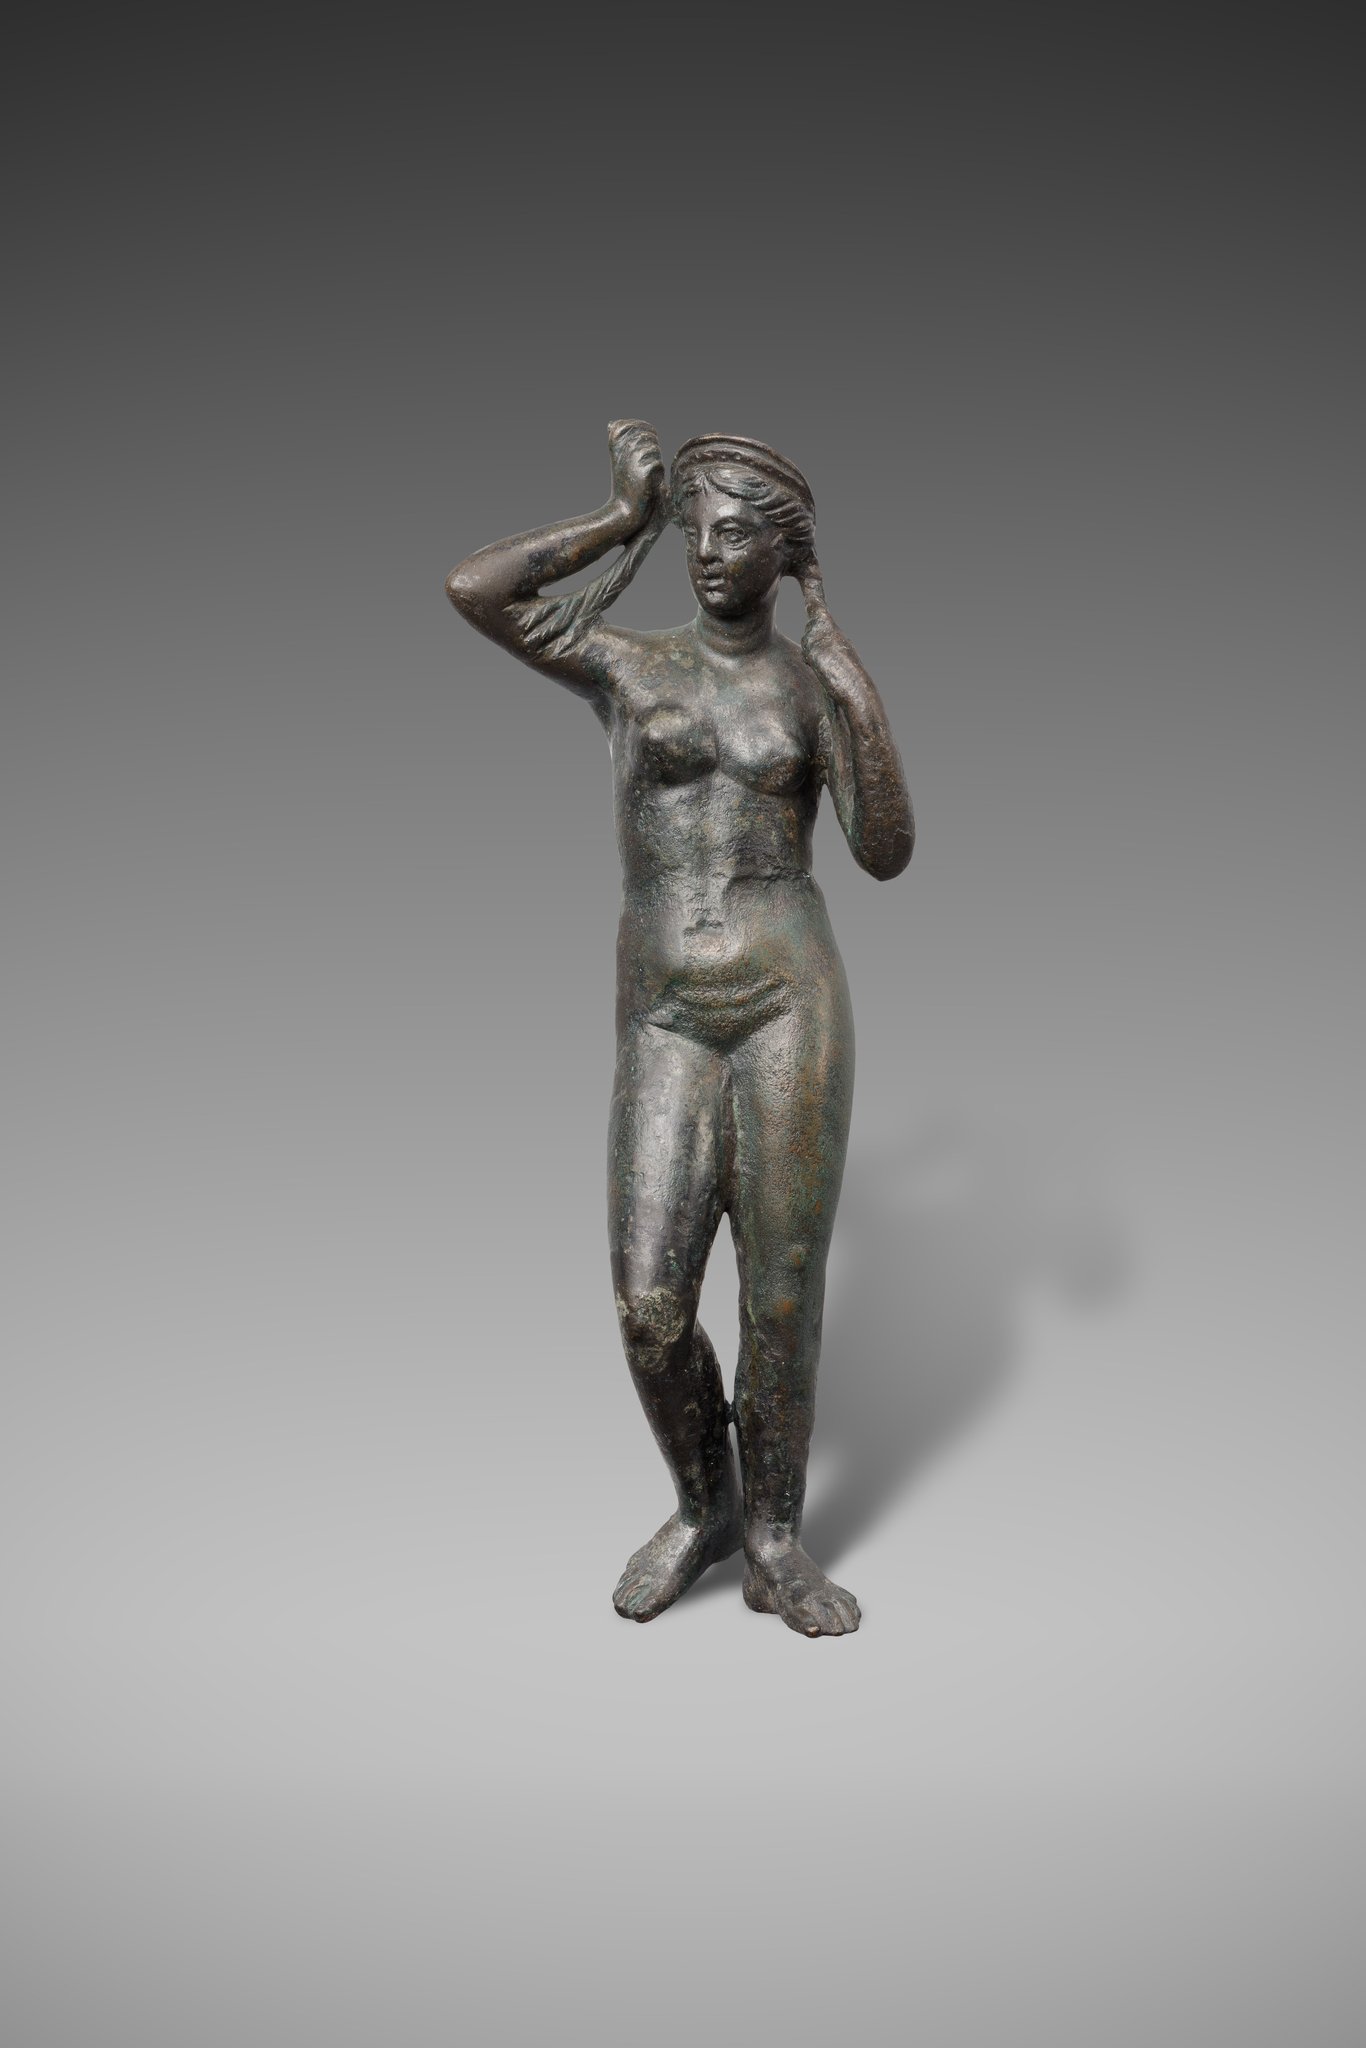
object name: statuette of aphrodite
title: Aphrodite rising from the Bath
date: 1-200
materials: bronze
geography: southern upper egypt